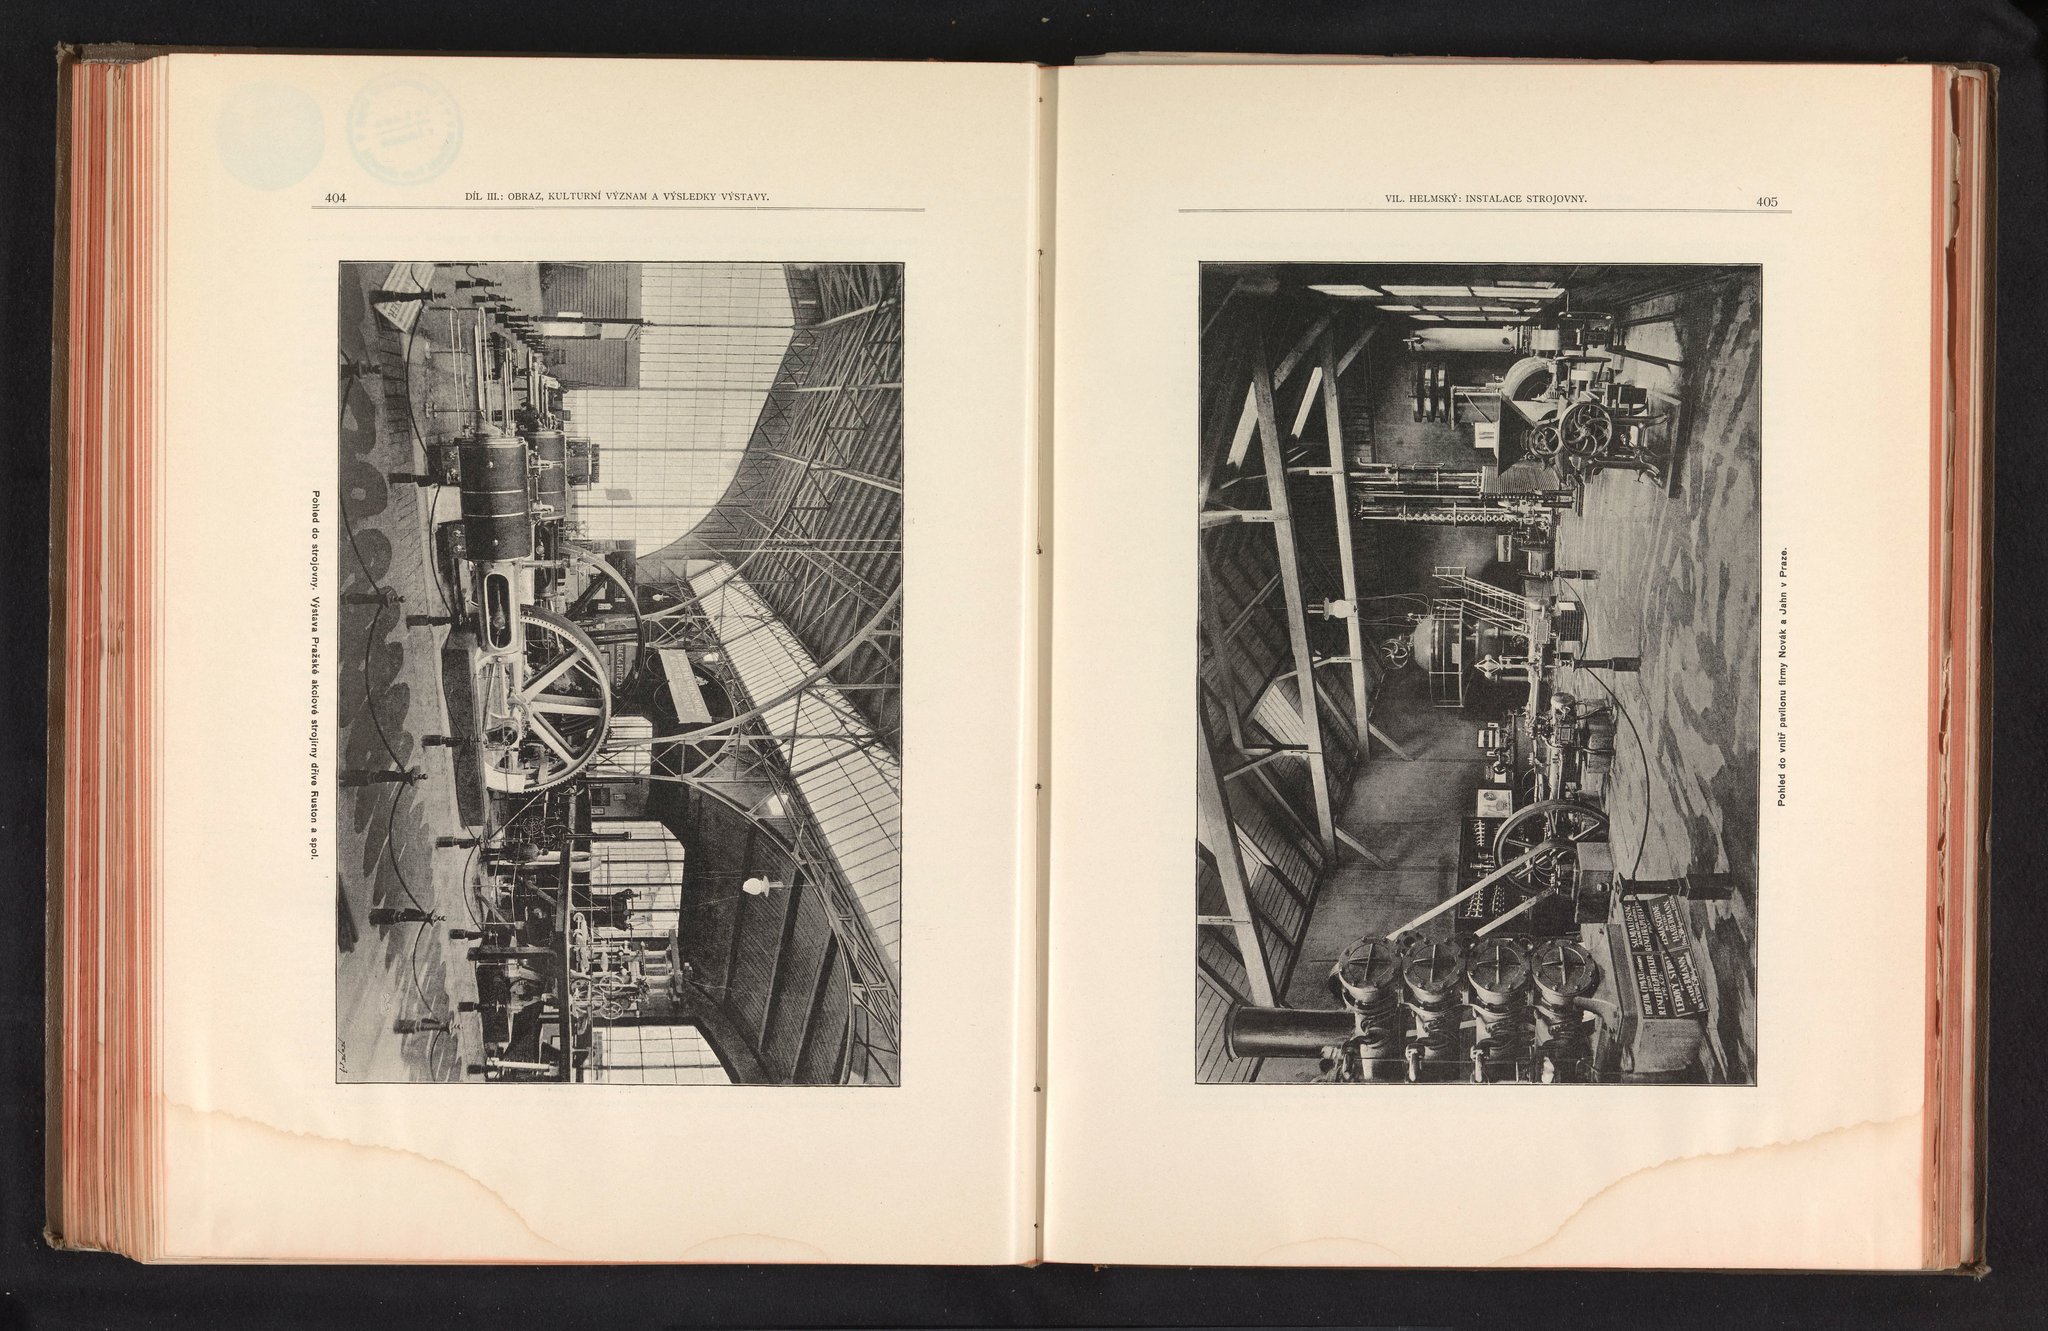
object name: photomechanical print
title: Pohled do strojovny. Výstava Prazské akciové strojirny drive Ruston a spol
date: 1890-1895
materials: paper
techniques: autotype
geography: prague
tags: machines; parts of machines; tools and appliances, interior ~ representation of a building